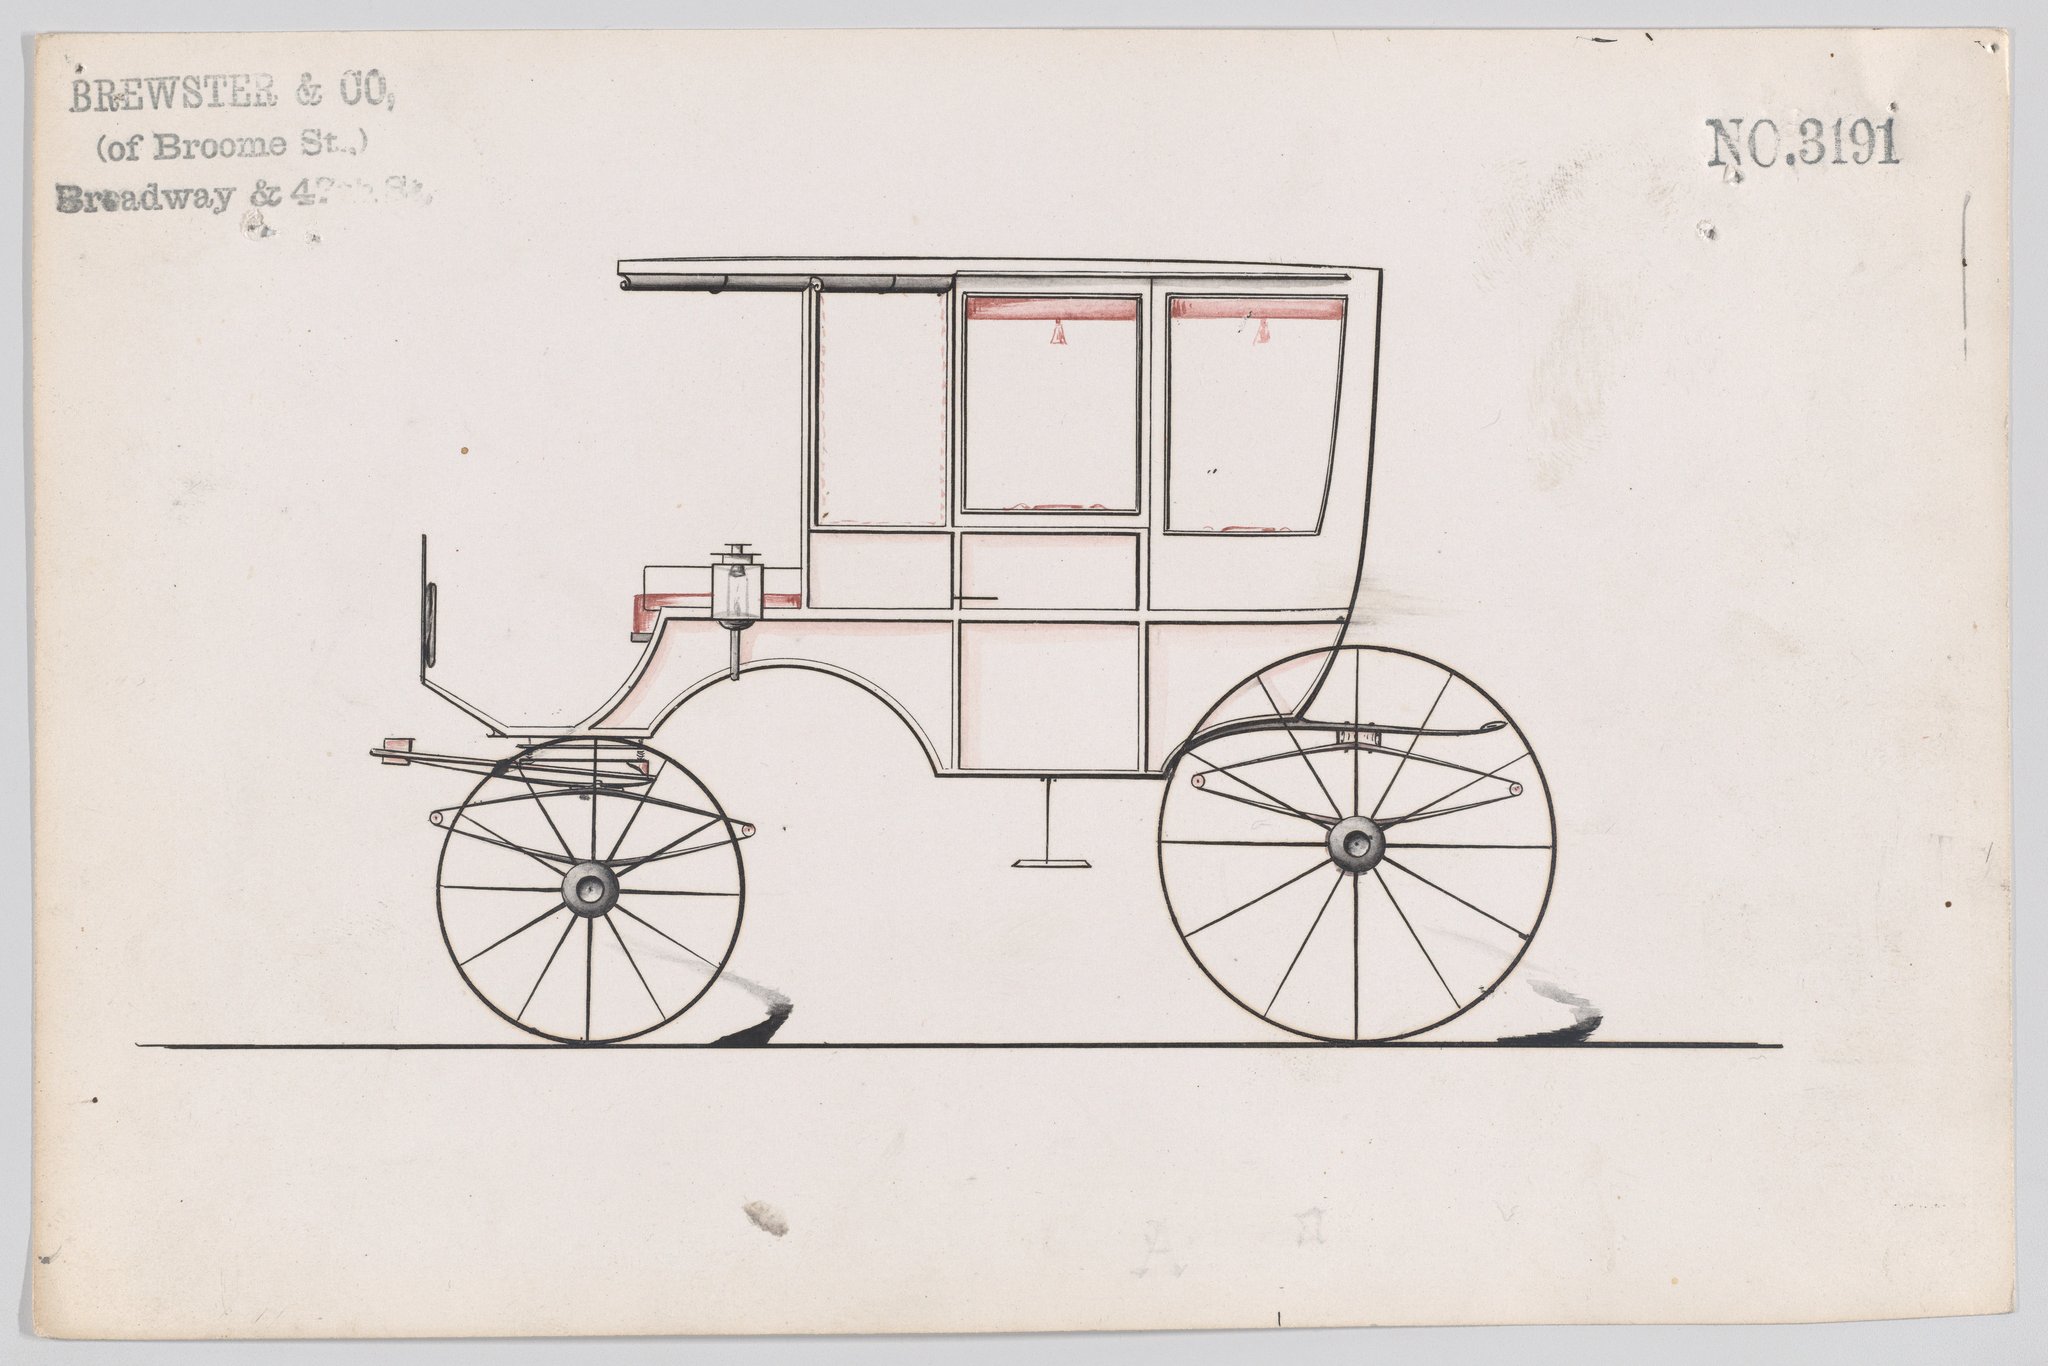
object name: drawing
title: Design for 6 seat Rockaway, no. 3191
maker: brewster & co.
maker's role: manufacturer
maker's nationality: american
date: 1876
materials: gouache, ink, watercolor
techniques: pen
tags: carriages